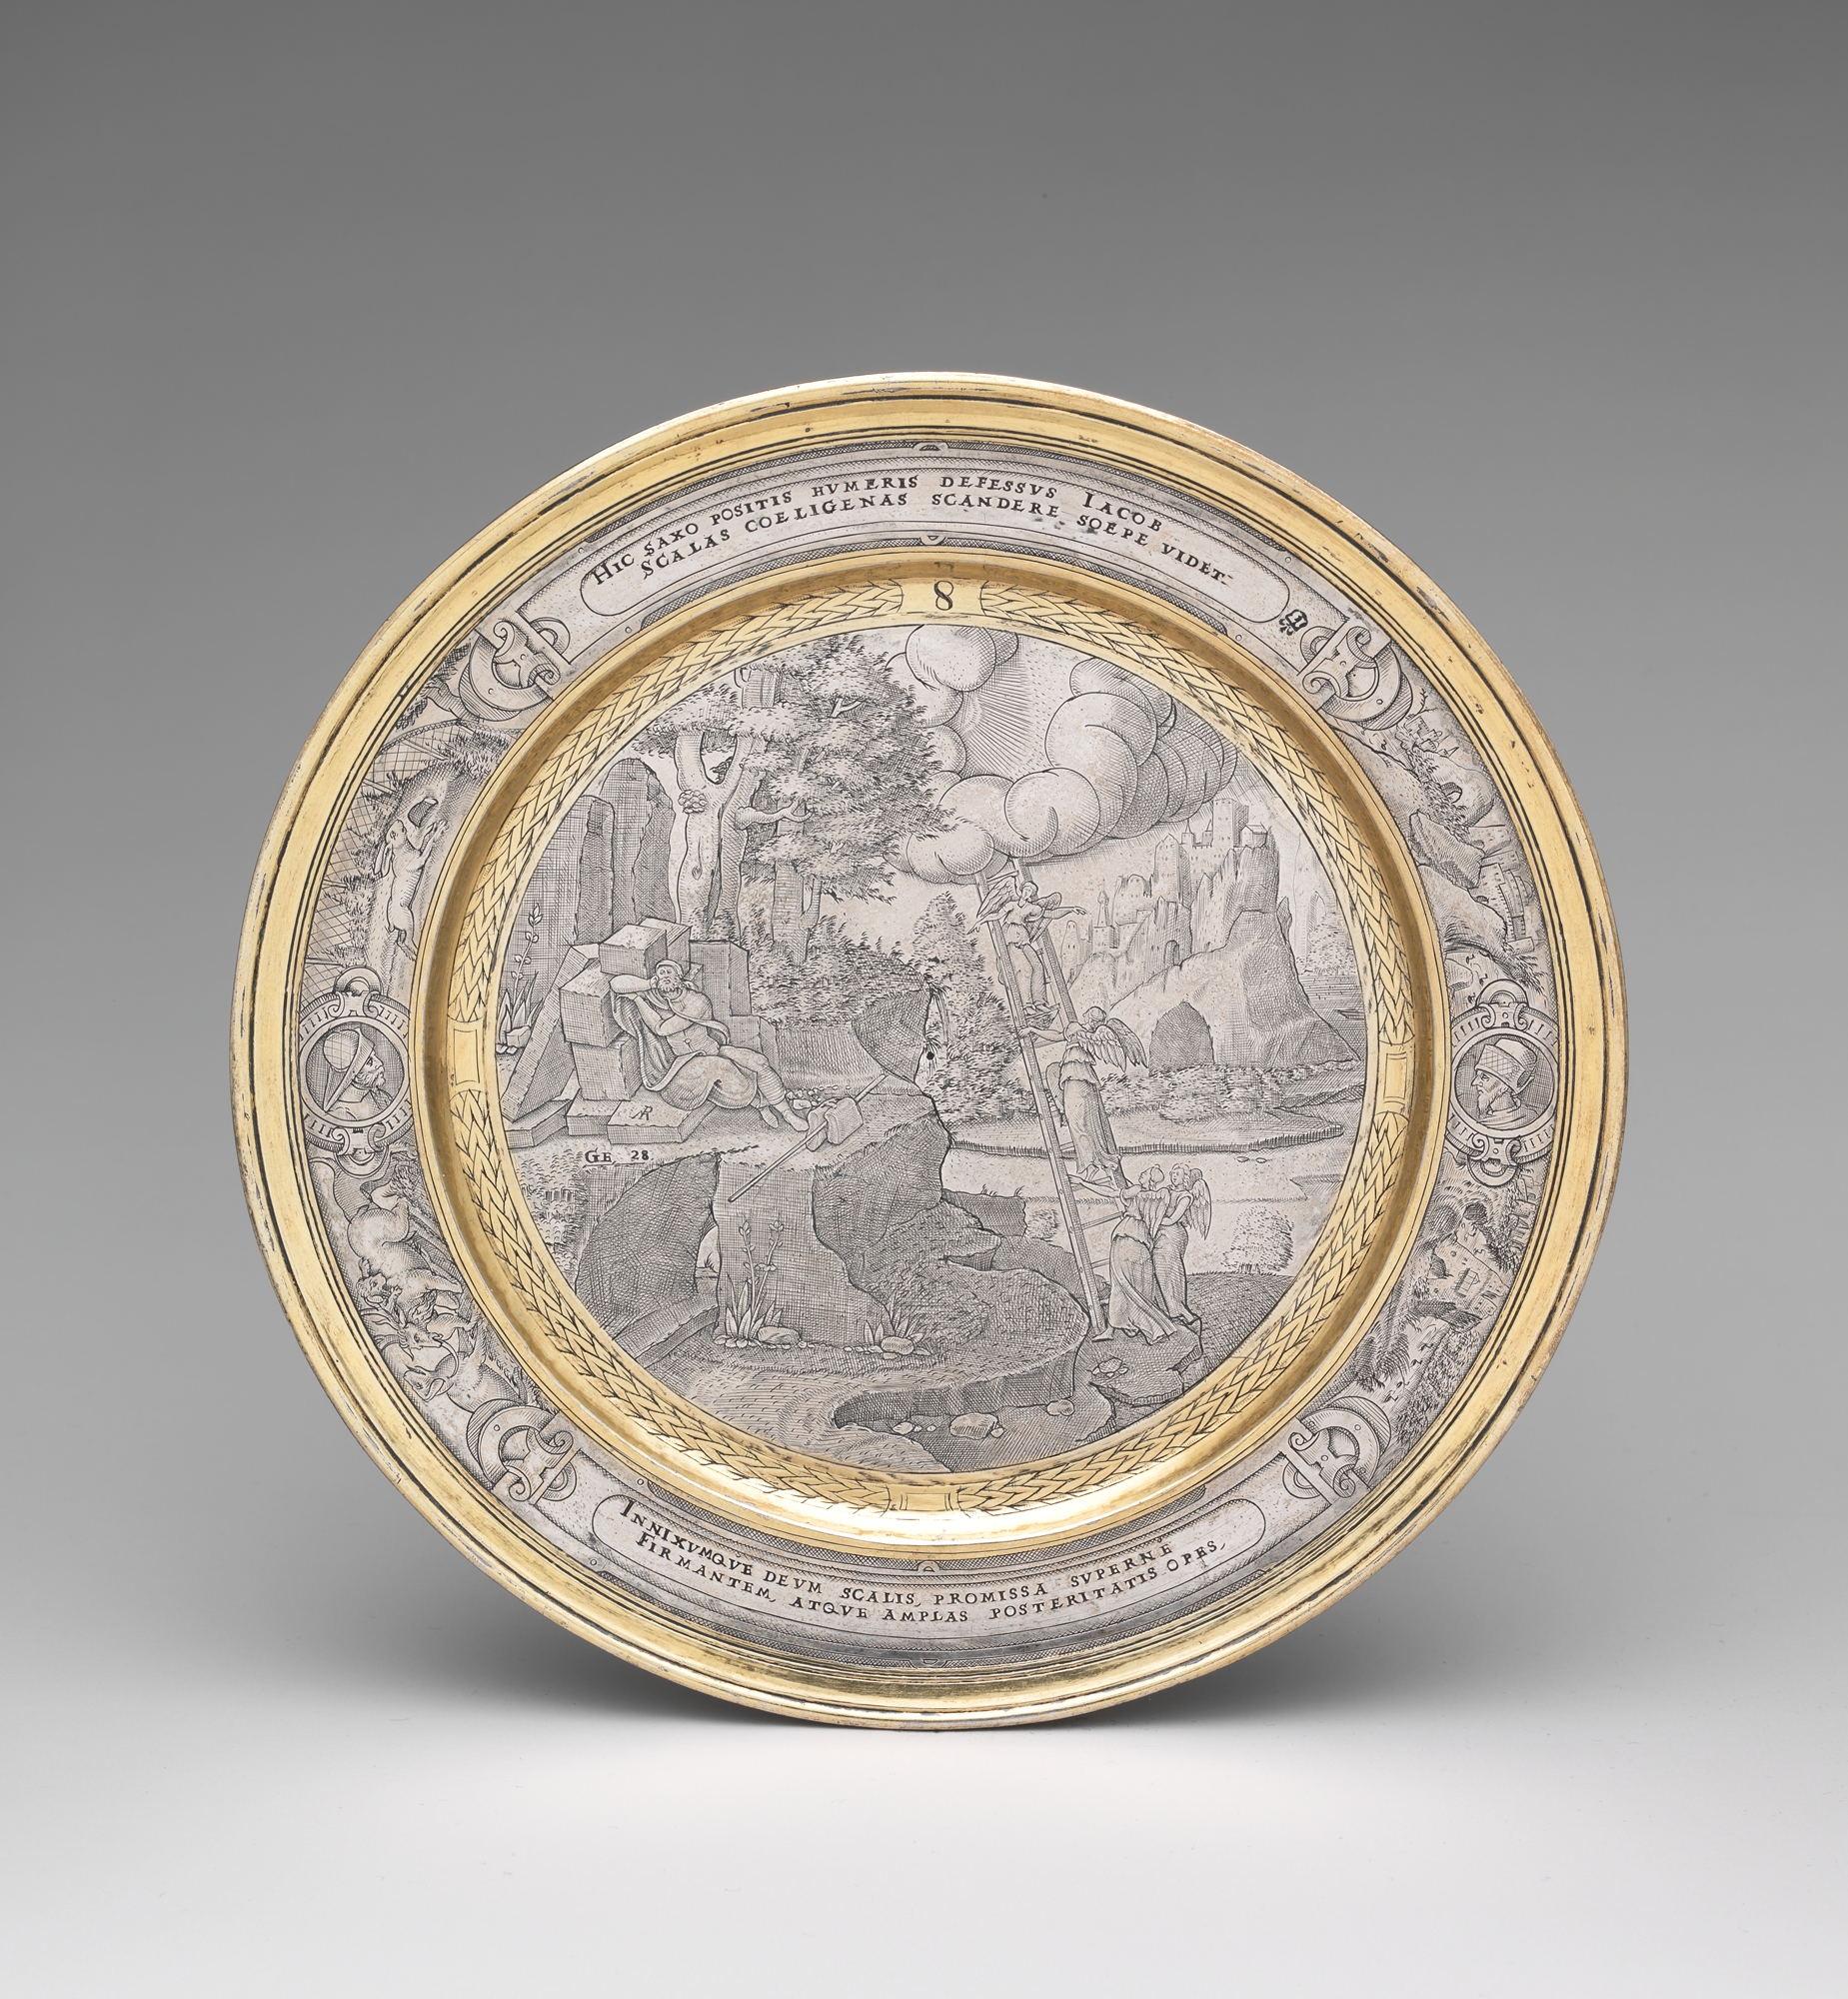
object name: plate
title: Jacob's Dream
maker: p.m.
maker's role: engraver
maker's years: 1500-1600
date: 1567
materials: silver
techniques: gilding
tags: men,angels,ladders